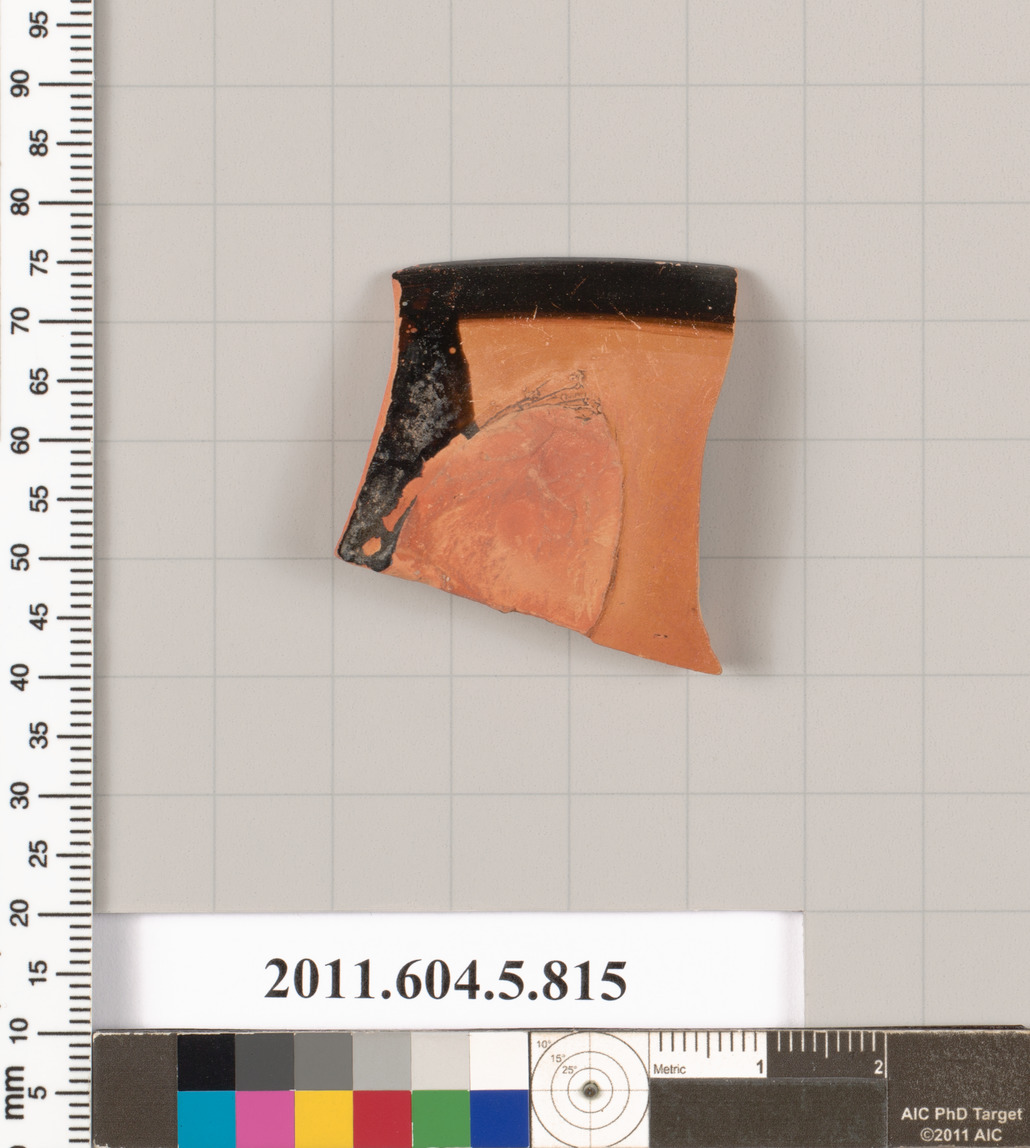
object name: kylix fragment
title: Terracotta rim fragment of a kylix (drinking cup)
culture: greek, attic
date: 600-401 BCE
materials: terracotta